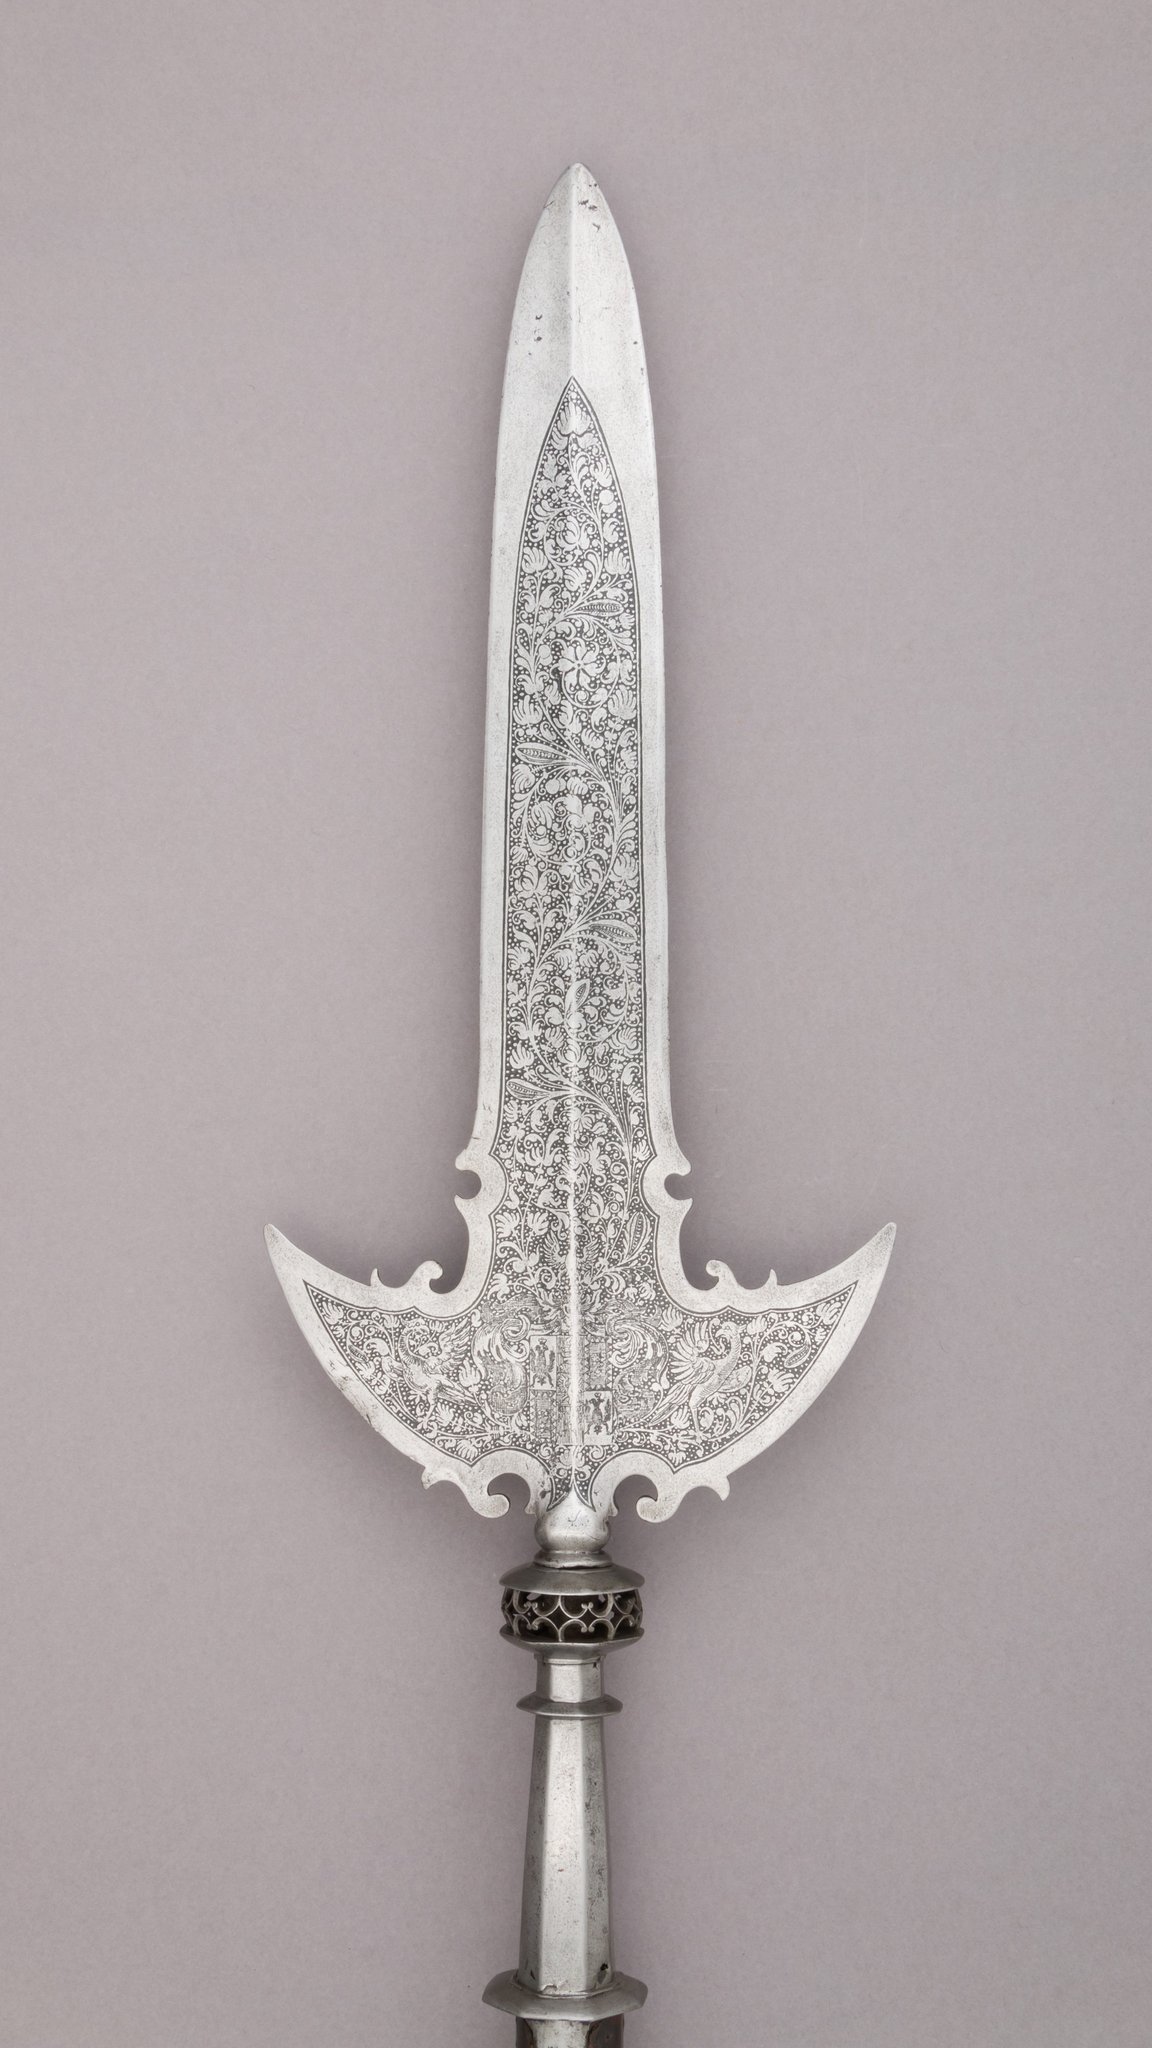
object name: partisan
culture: italian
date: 1610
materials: steel, textile, wood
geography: italy